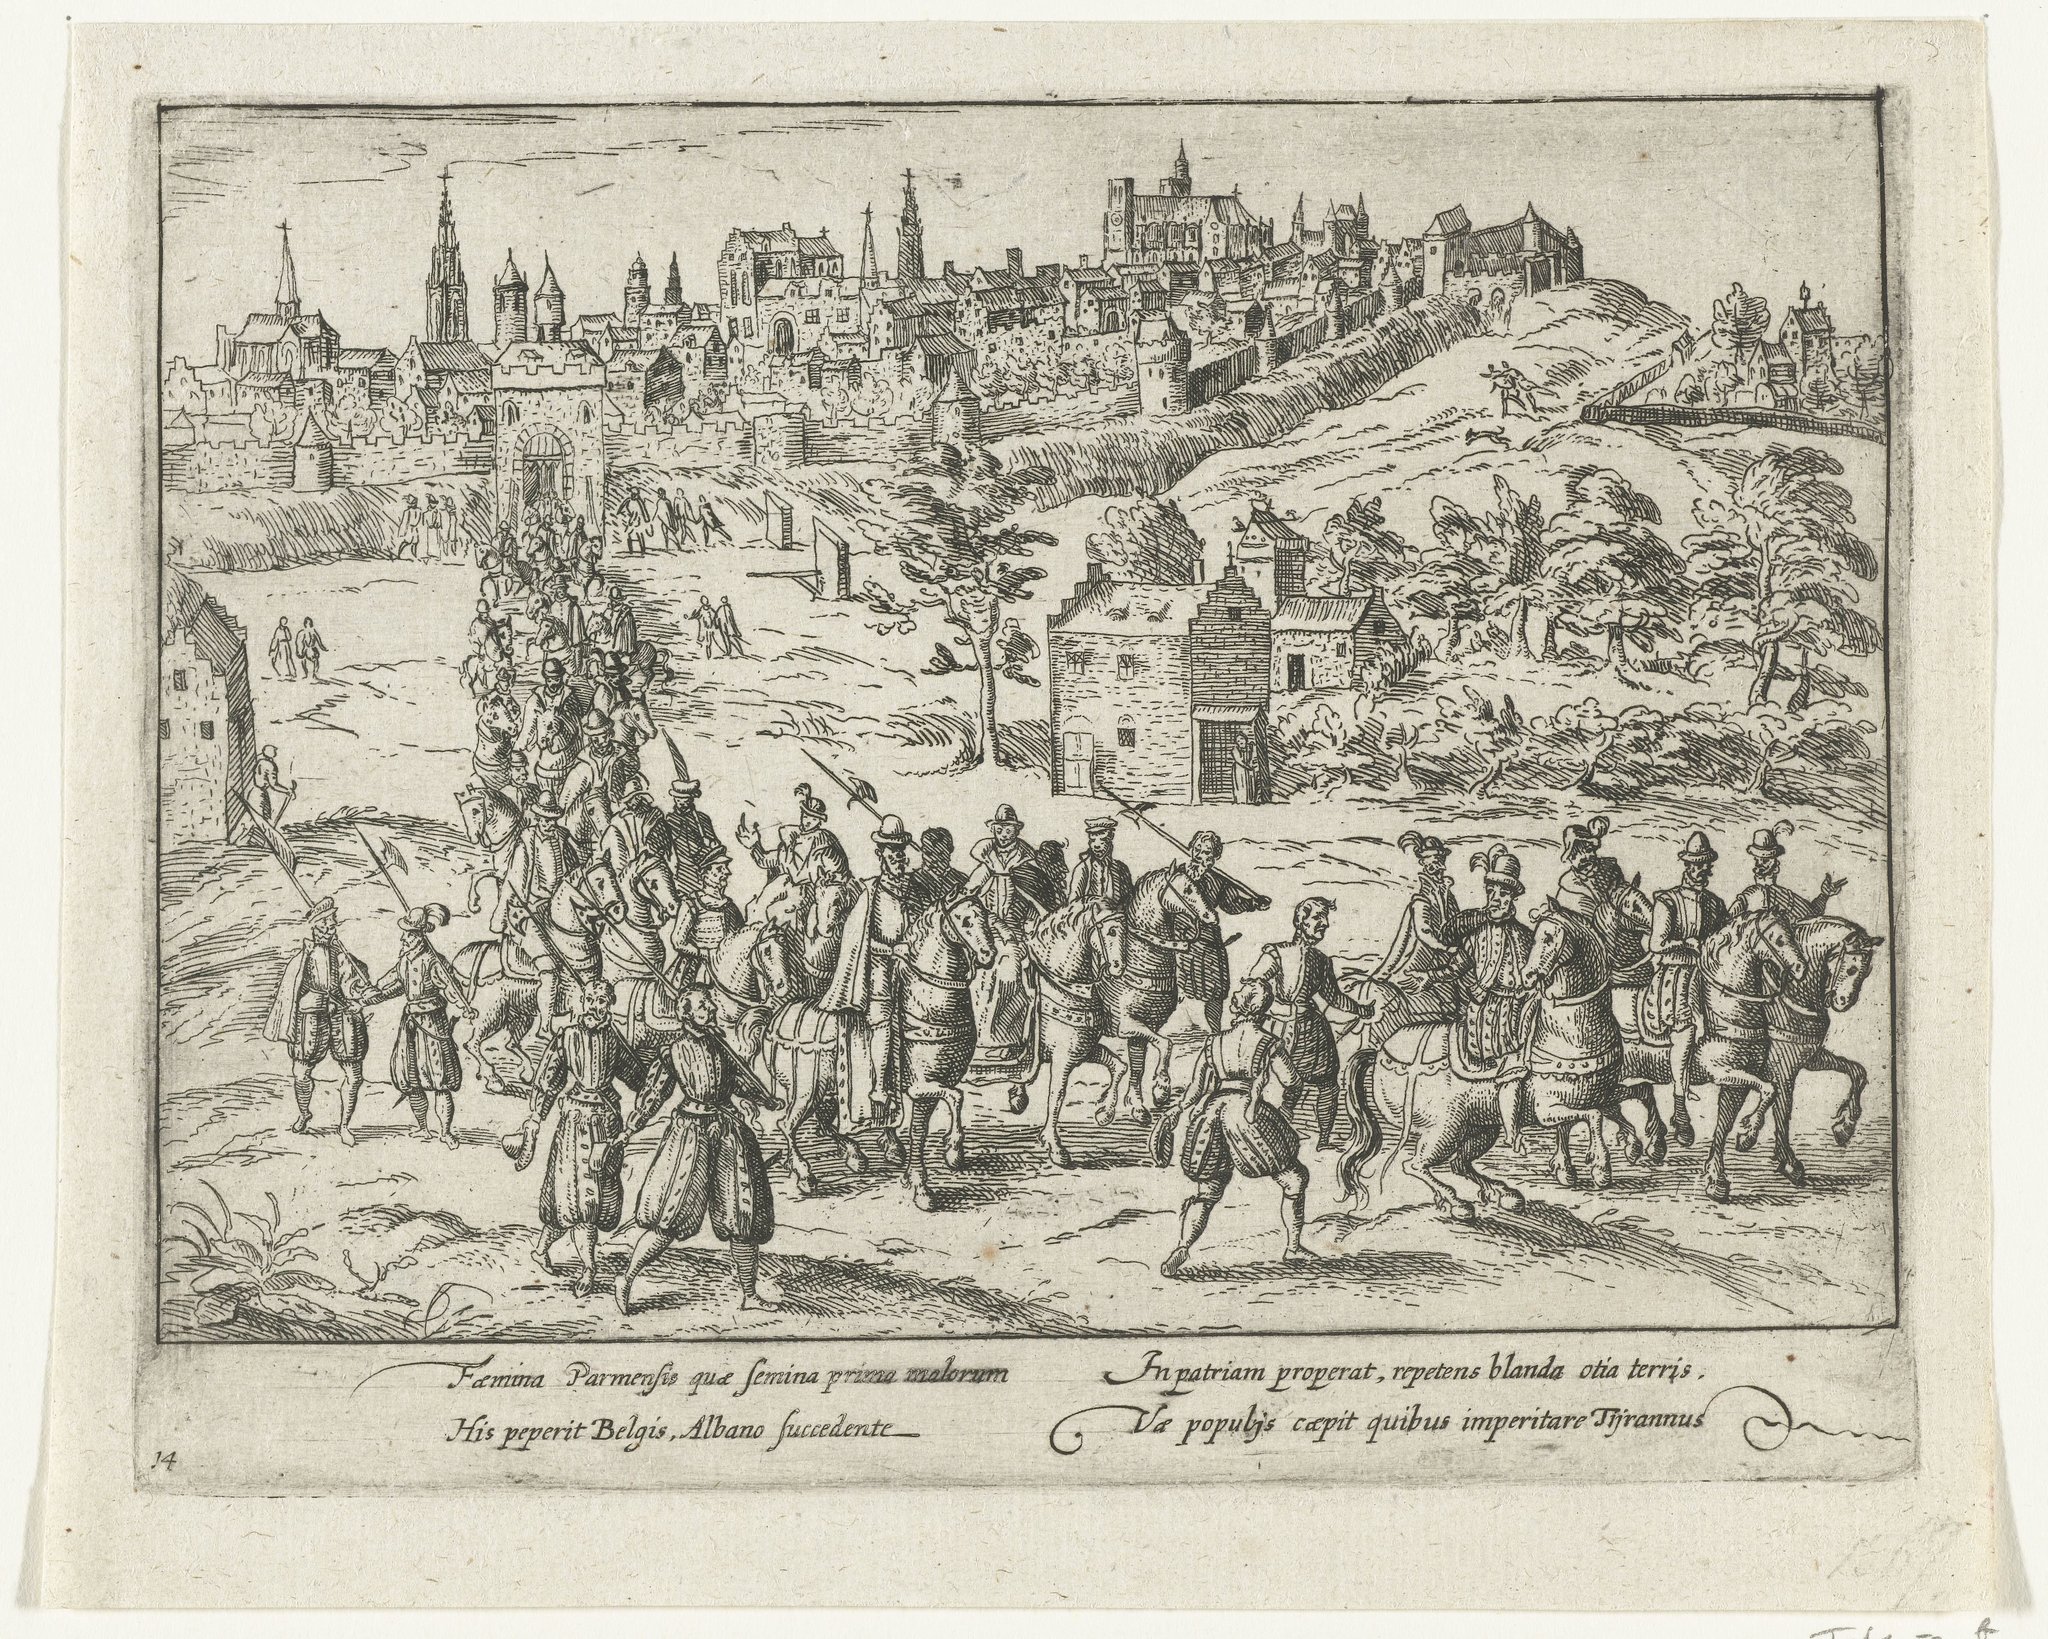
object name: history print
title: Margaretha van Parma vertrekt uit Brussel, 1567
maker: Anonymous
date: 1613-1615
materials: paper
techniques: etching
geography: cologne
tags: fernando álvarez de toledo (3rd duke of alba), brussels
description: Margaretha van Parma wordt bij haar vertrek uit Brussel uitgeleid door de hertog van Alva, 30 december 1567. De stoet van ruiters rijdt uit de stadspoort. Met onderschrift van 4 regels in het Latijn. Genummerd: 14. De achterzijde onbedrukt.